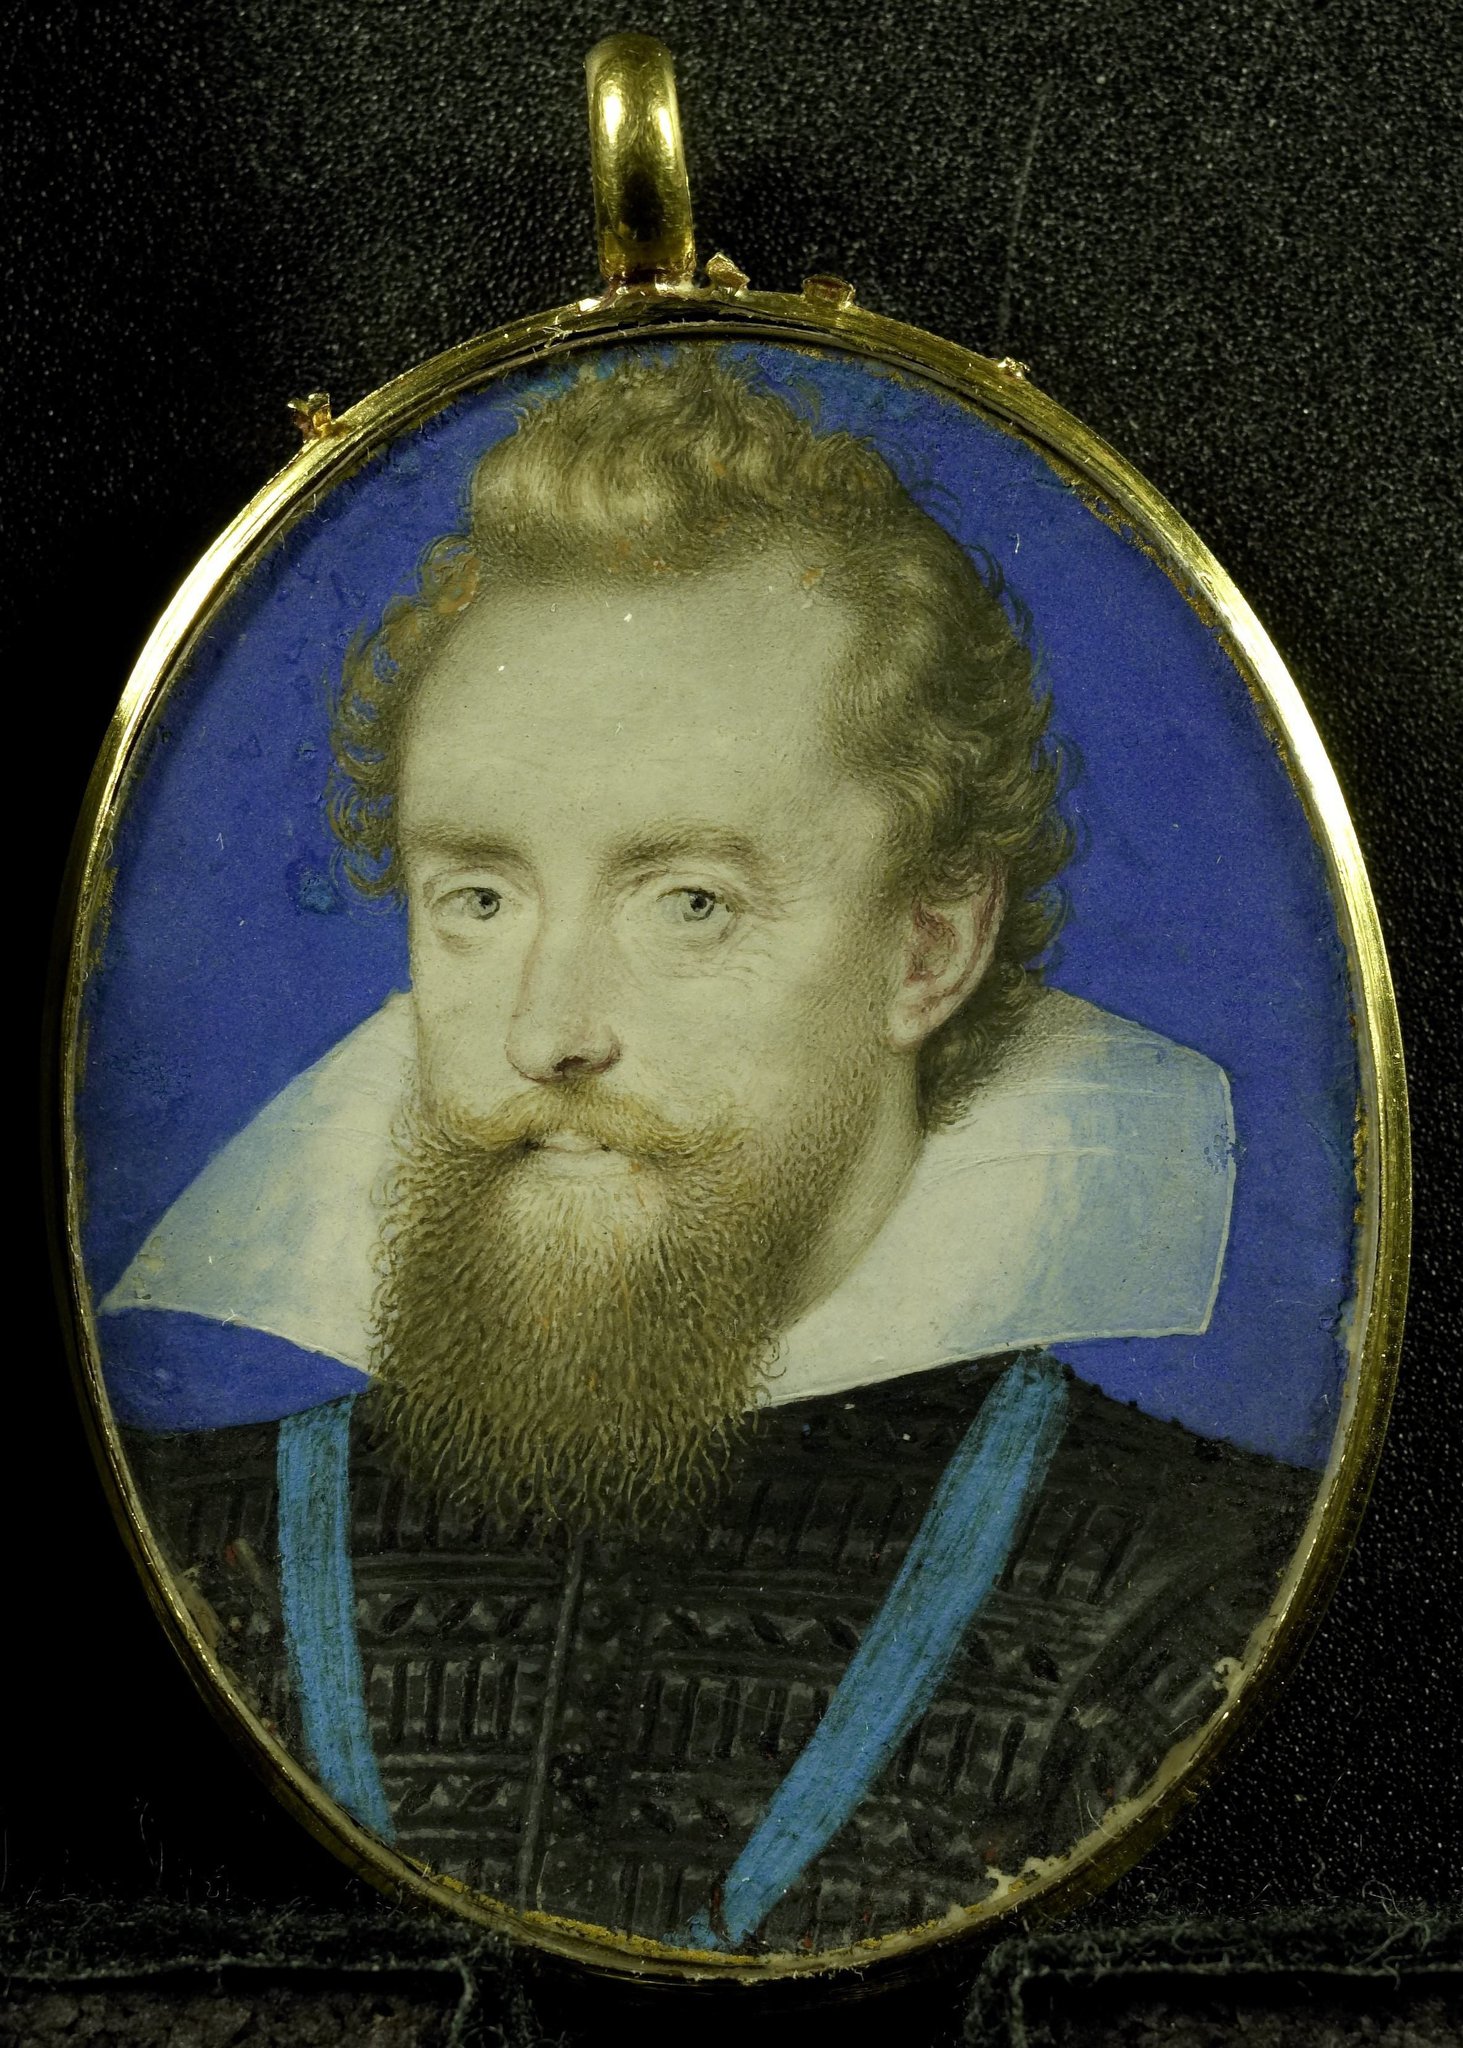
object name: painting, miniature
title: Ludovic Stuart (1574-1623/1624), eerste hertog van Richmond en tweede hertog van Lennox of Thomas Howard (1561-1628), graaf van Suffolk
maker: isaac oliver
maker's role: draughtsman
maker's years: 1565-1617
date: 1580-1617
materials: glass, metal, parchment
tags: politician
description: Portret van Ludovic Stuart (1574-1623/1624), eerste hertog van Richmond en tweede hertog van Lennox of van Thomas Howard (1561-1628), graaf van Suffolk. Buste, naar links.